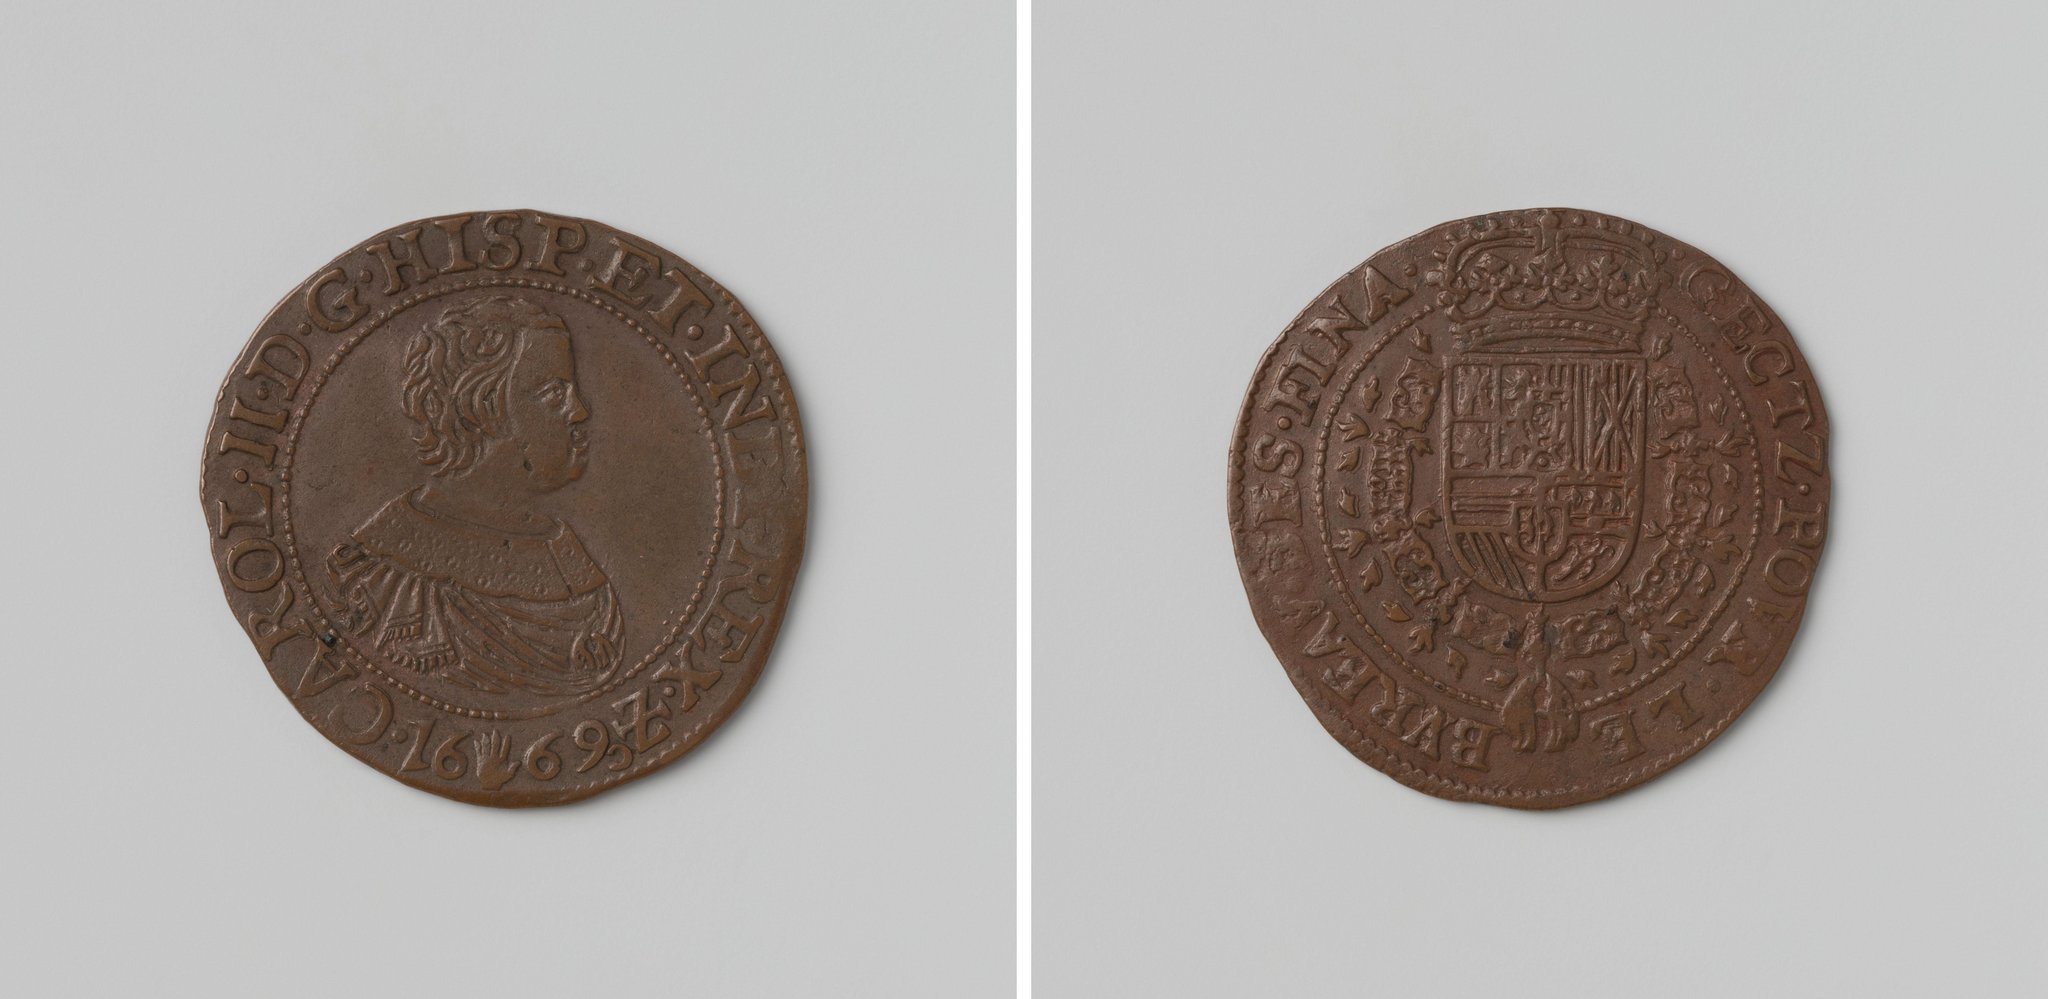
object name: jeton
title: Karel II, koning van Spanje, rekenpenning geslagen op last van de raad van Financiën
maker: Anonymous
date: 1669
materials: copper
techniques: striking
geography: antwerp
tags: karel ii (koning van spanje)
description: Koperen penning. Voorzijde: borststuk man binnen omschrift. Keerzijde: gekroond wapenschild, omhangen met de orde van het Gulden Vlies binnen omschrift